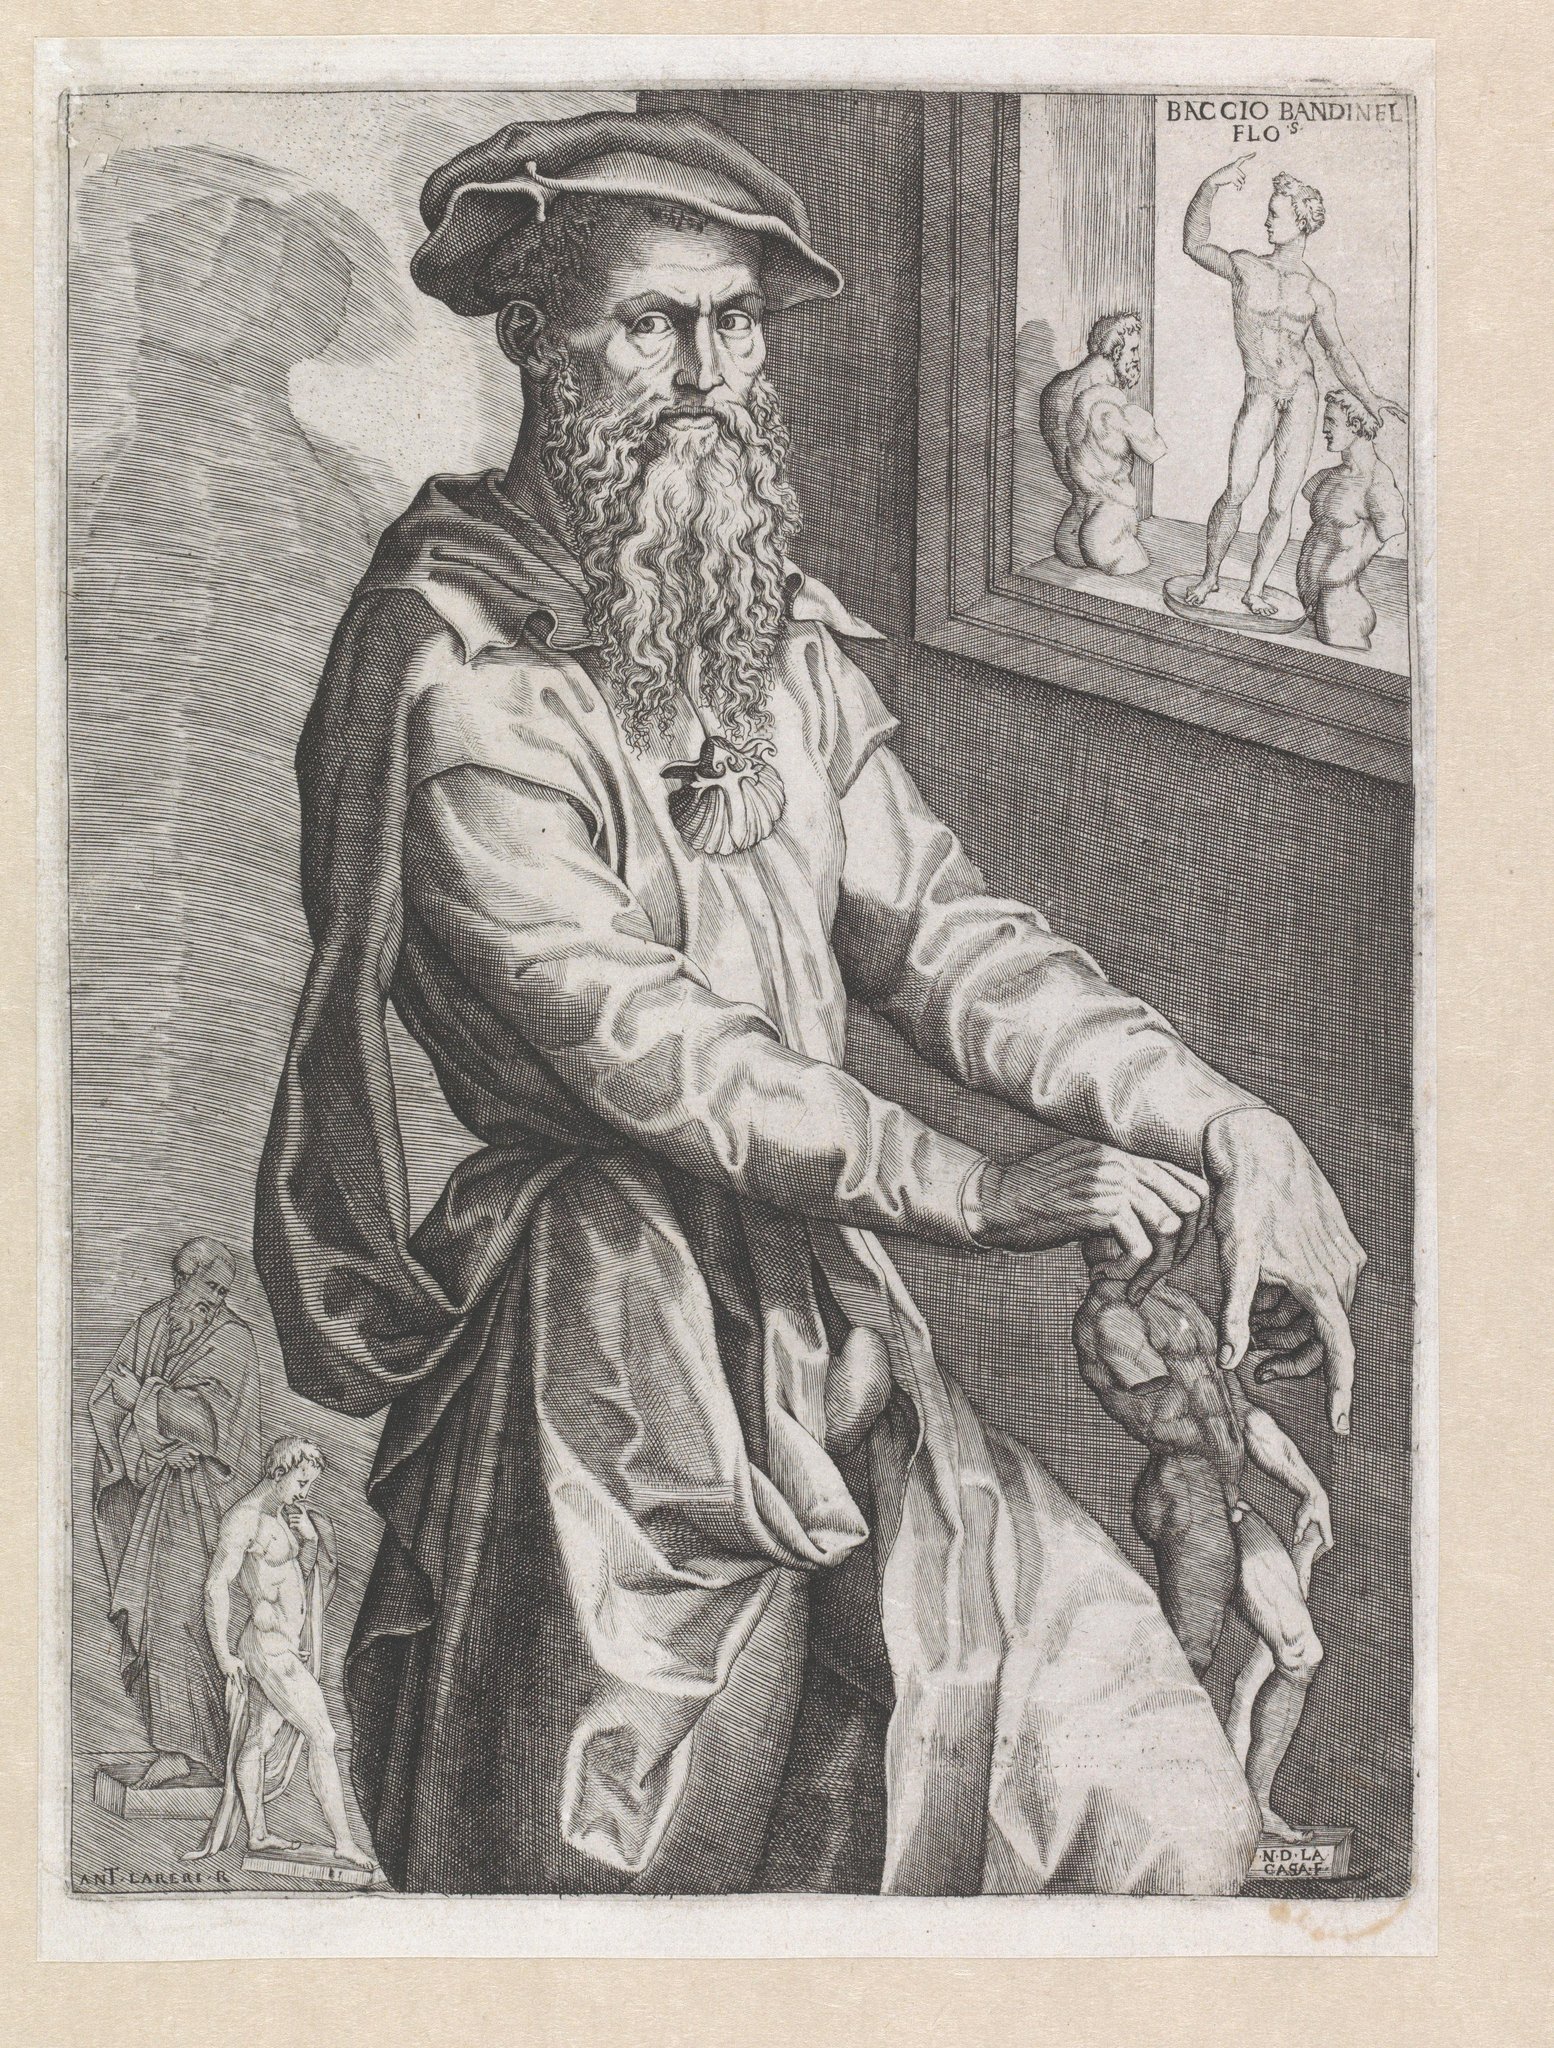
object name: print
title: Portret van beeldhouwer Baccio Bandinelli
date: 1538-1552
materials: paper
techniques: engraving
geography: italy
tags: draughtsman, baccio bandinelli, portrait, self-portrait of sculptor, sculptor making a model, bozzetto, portrait, self-portrait of artist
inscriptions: collector's mark: Lugt 240